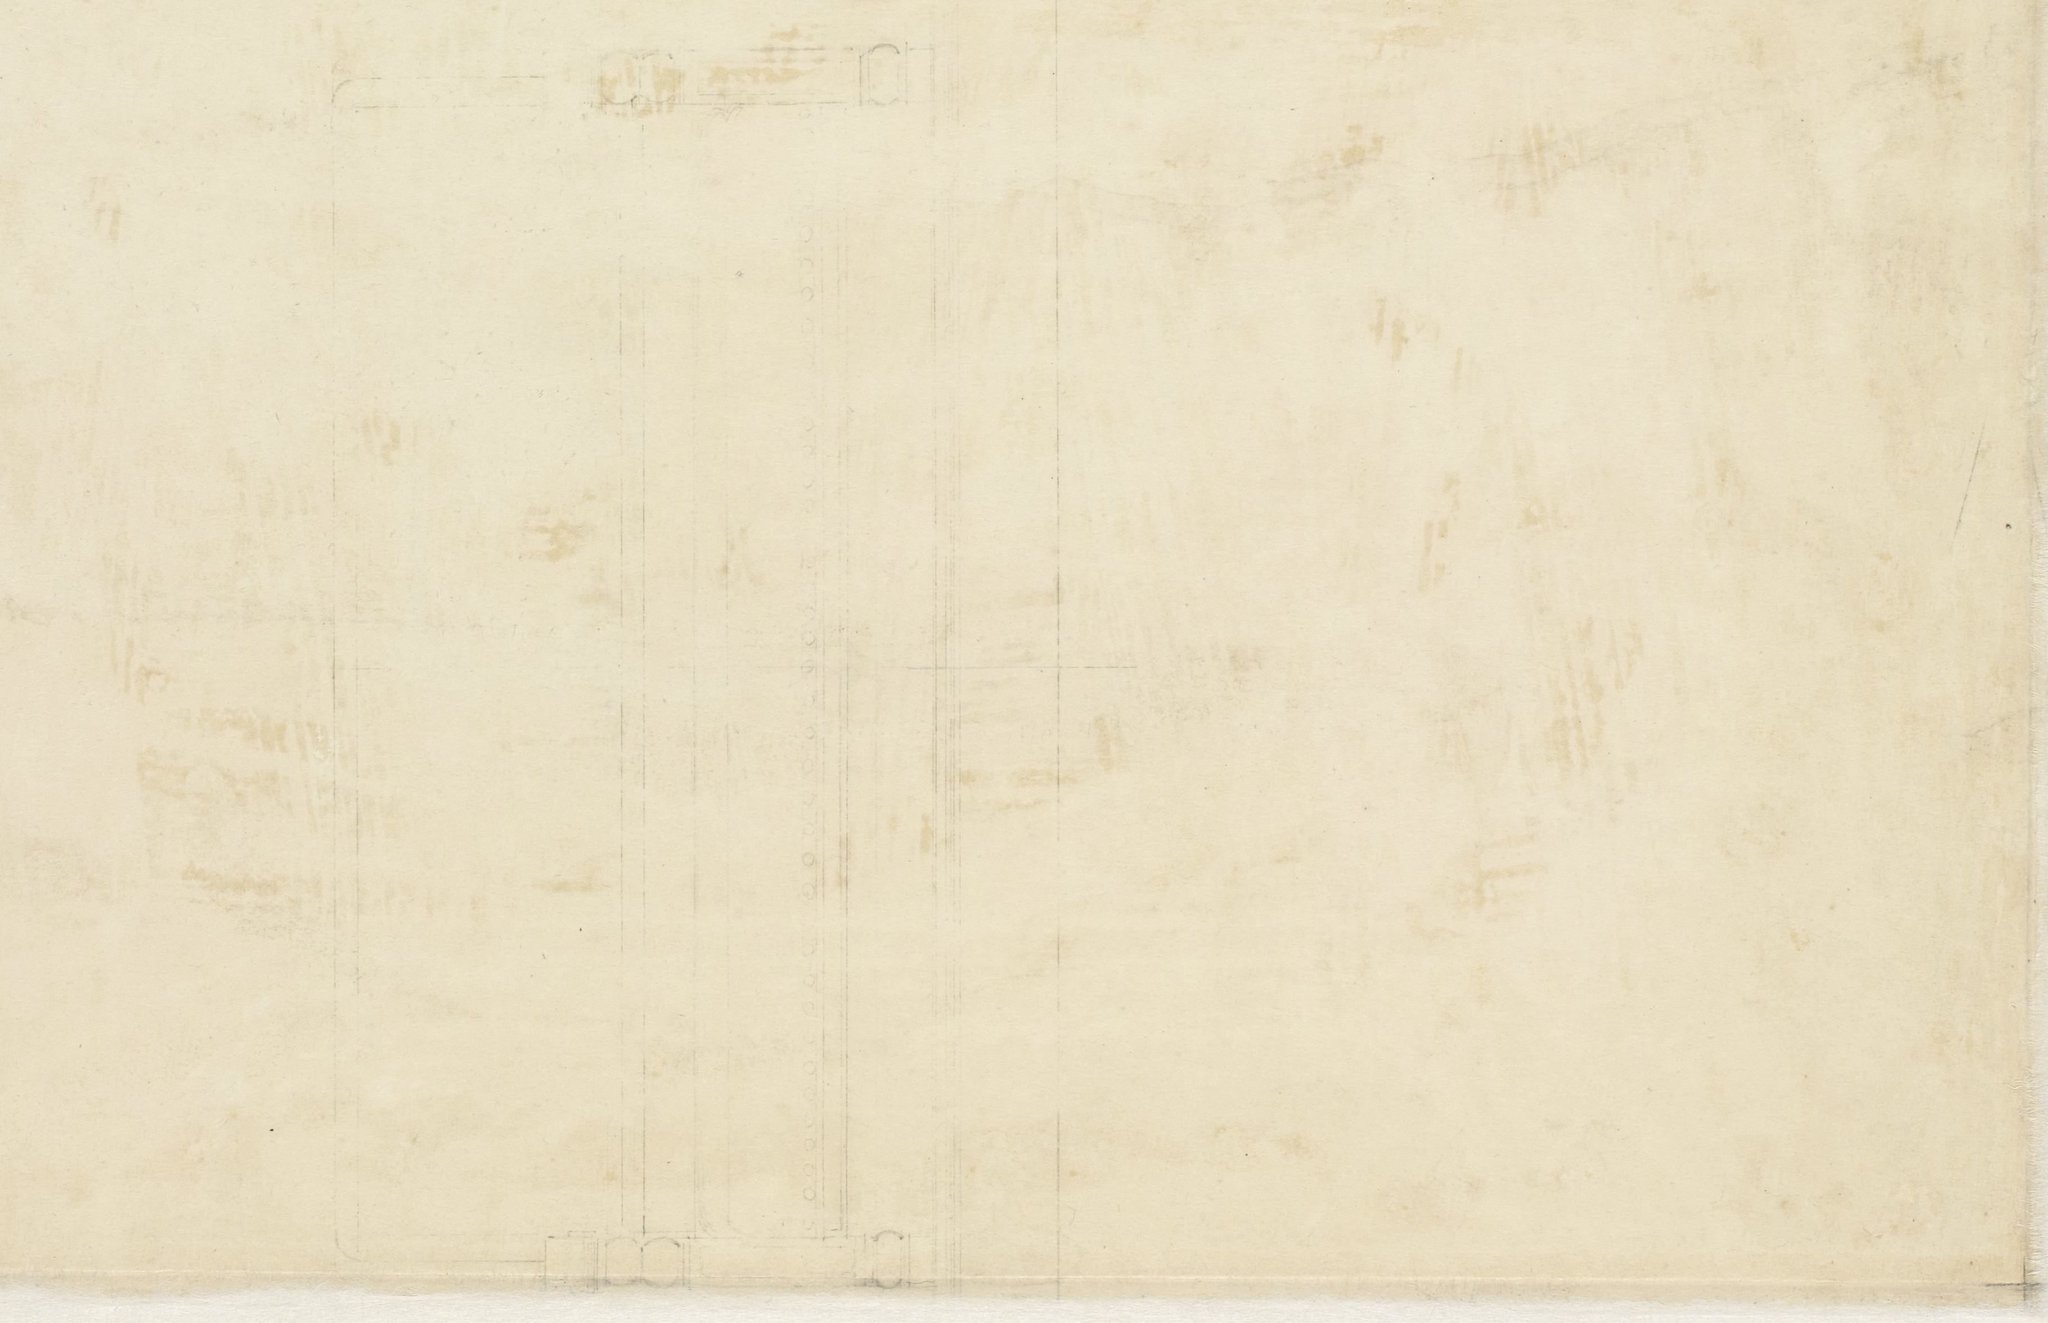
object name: drawing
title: Bank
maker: monogrammist hk (nederland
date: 1925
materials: paper, pencil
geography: amsterdam